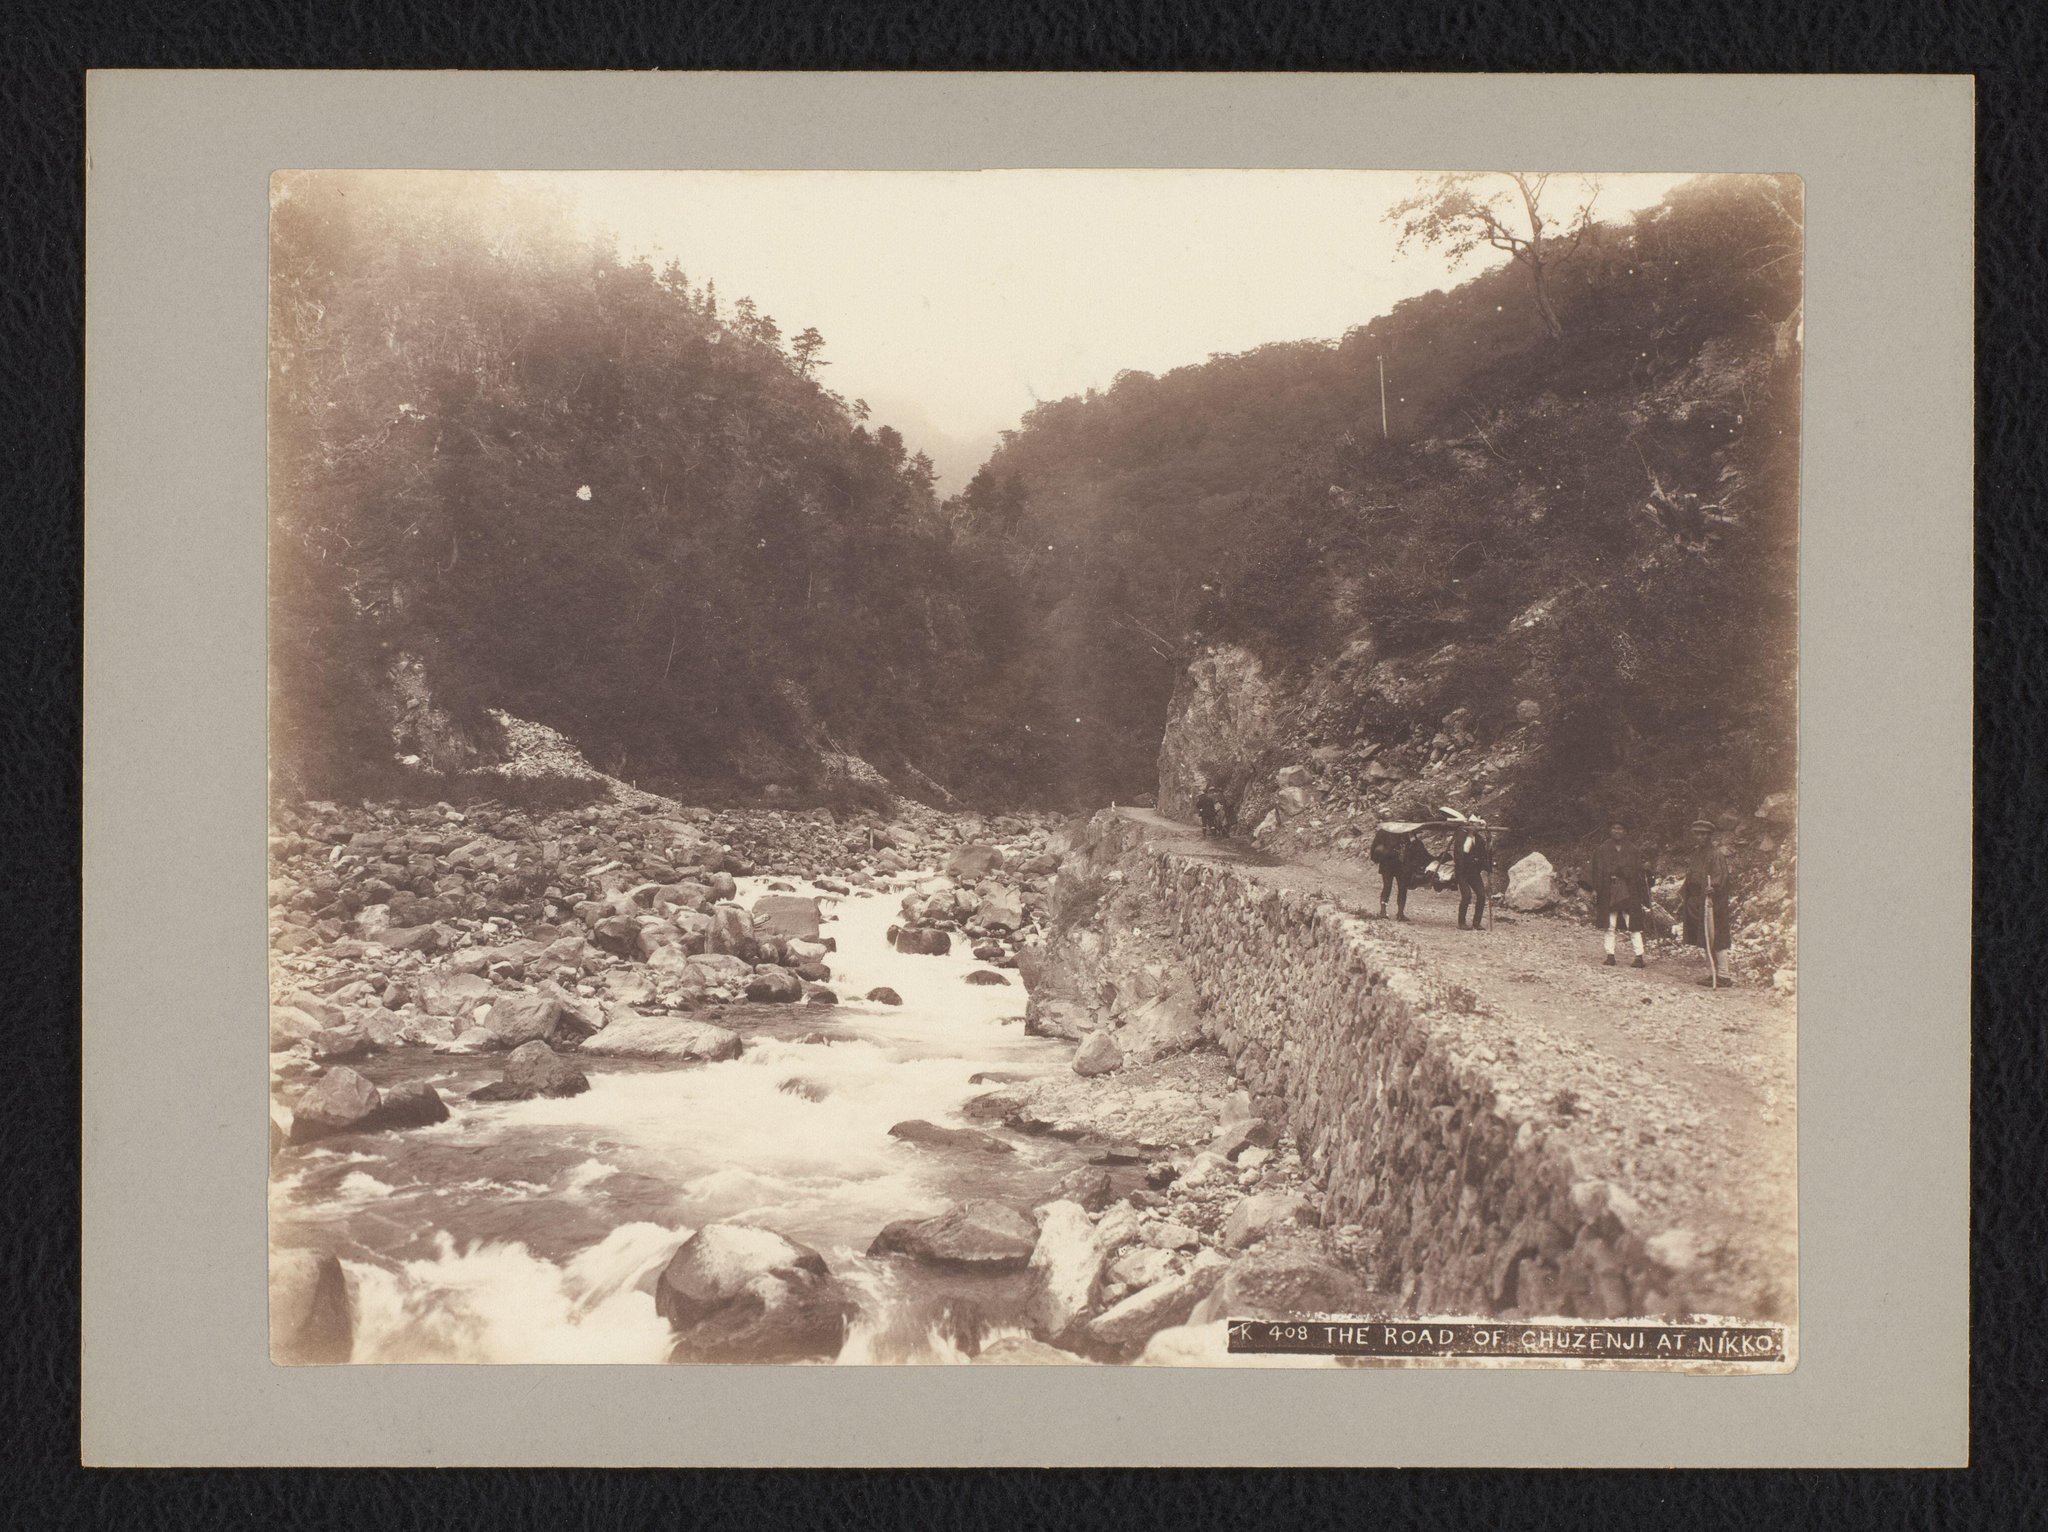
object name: photograph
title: K 408 The road of Chuzenji at Nikko.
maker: Anonymous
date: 1895-1915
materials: cardboard, photographic support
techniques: salted paper print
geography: nikko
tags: nikko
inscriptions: number: ‘40.’